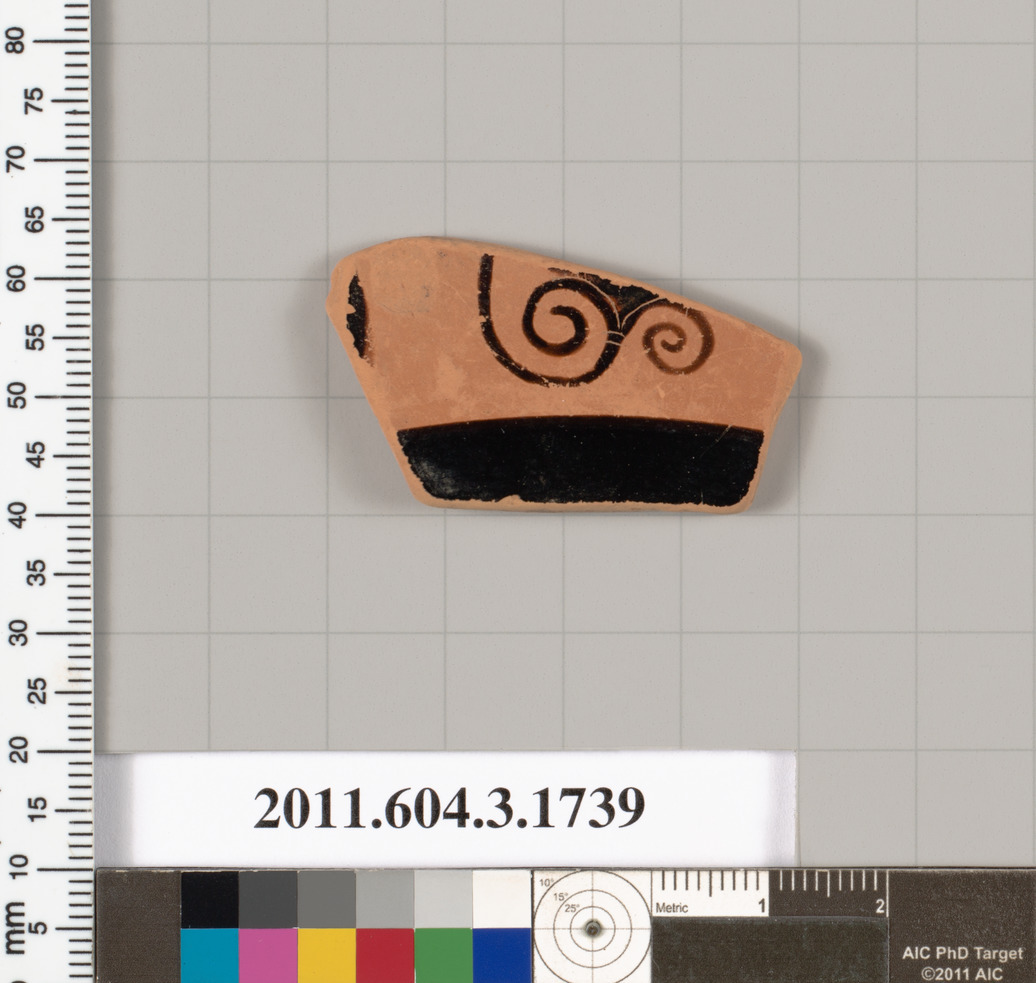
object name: kylix fragment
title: Terracotta fragment of a kylix: Lip cup (drinking cup)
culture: greek, attic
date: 550-526 BCE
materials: terracotta